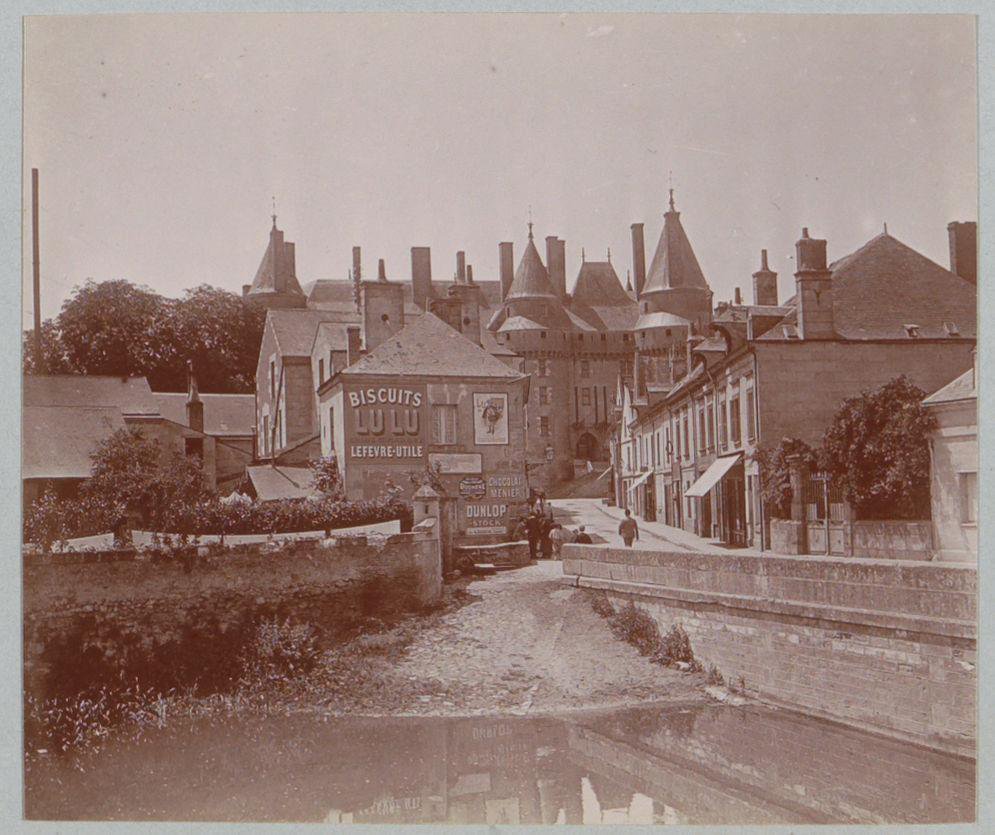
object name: photograph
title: Gezicht op huizen, torens en reclameborden, vermoedelijk in Saumur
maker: Anonymous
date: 1905-1910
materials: paper, photographic support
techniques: gelatin silver print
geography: saumur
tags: advertising, tower, clock tower ~ monumental adornment, prospect of city, town panorama, silhouette of city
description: Onderdeel van Fotoalbum van een Franse amateurfotograaf met bezienswaardigheden in Frankrijk, Zwitserland en Italië.